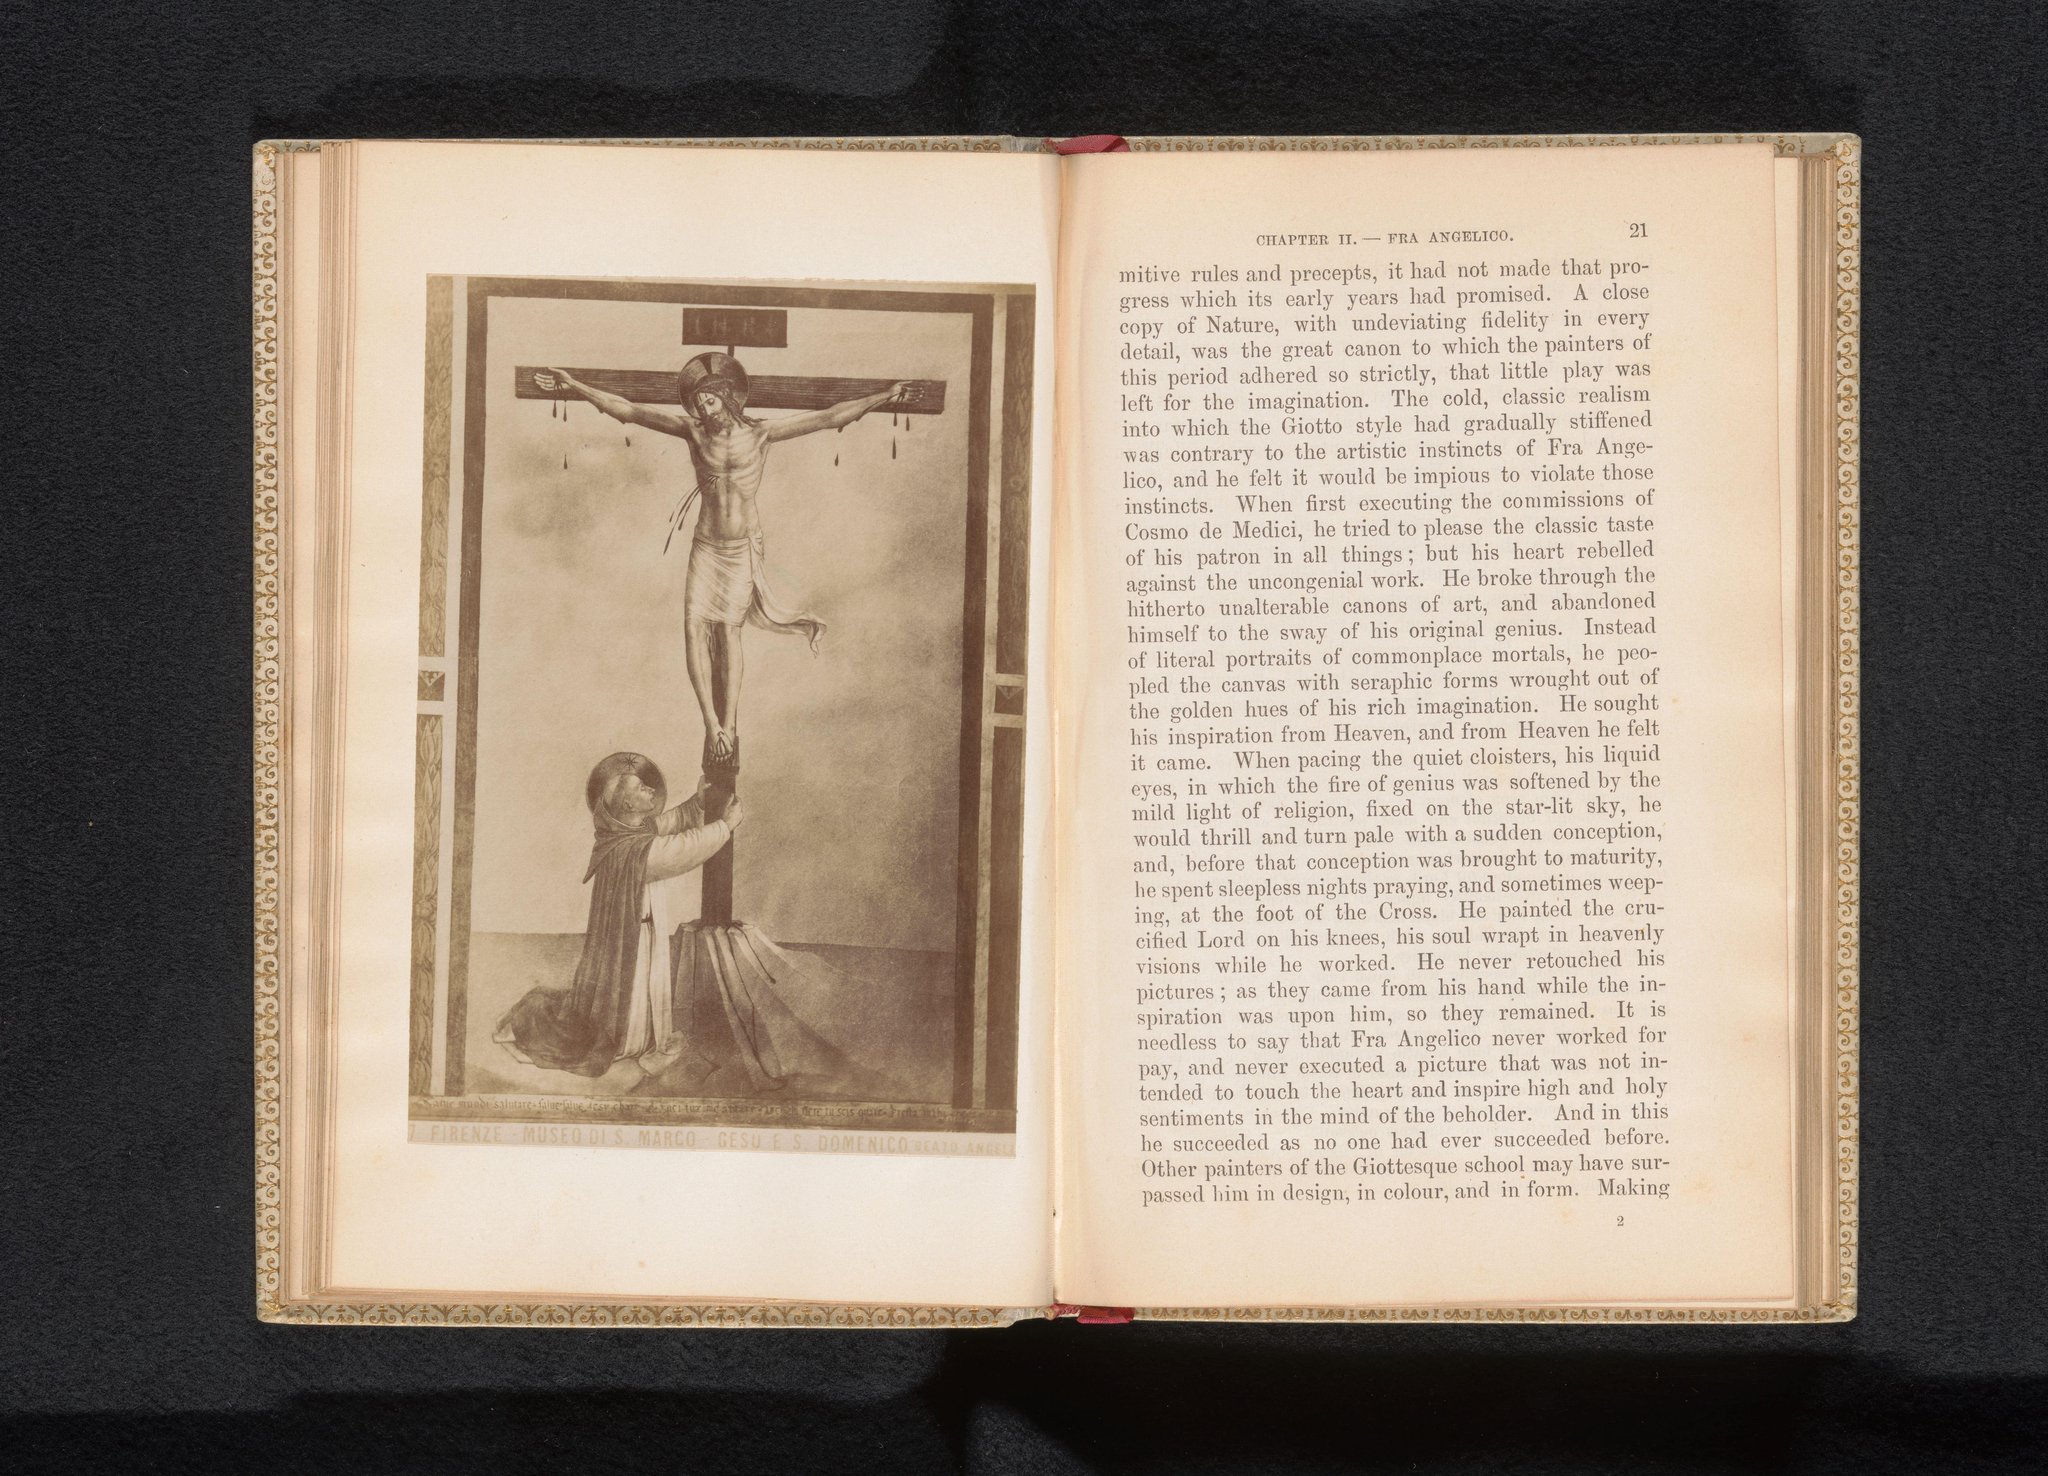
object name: photograph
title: Fotoreproductie van een fresco in het San Marco-klooster te Florence, voorstellende de aanbidding van Christus aan het kruis door de heilige Dominicus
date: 1880-1890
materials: photographic support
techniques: albumen print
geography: san marco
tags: dominic(us) guzman of calerueja, founder of the order of preachers (or dominican (black) friars; possible attributes: book, dog with flaming torch, lily, loaf of bread, rosary, star, the crucifixion of christ: christ's death on the cross; golgotha (matthew 27:45-58; mark 15:33-45; luke 23:44-52; john 19:25-38)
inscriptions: number: ‘[...]7’